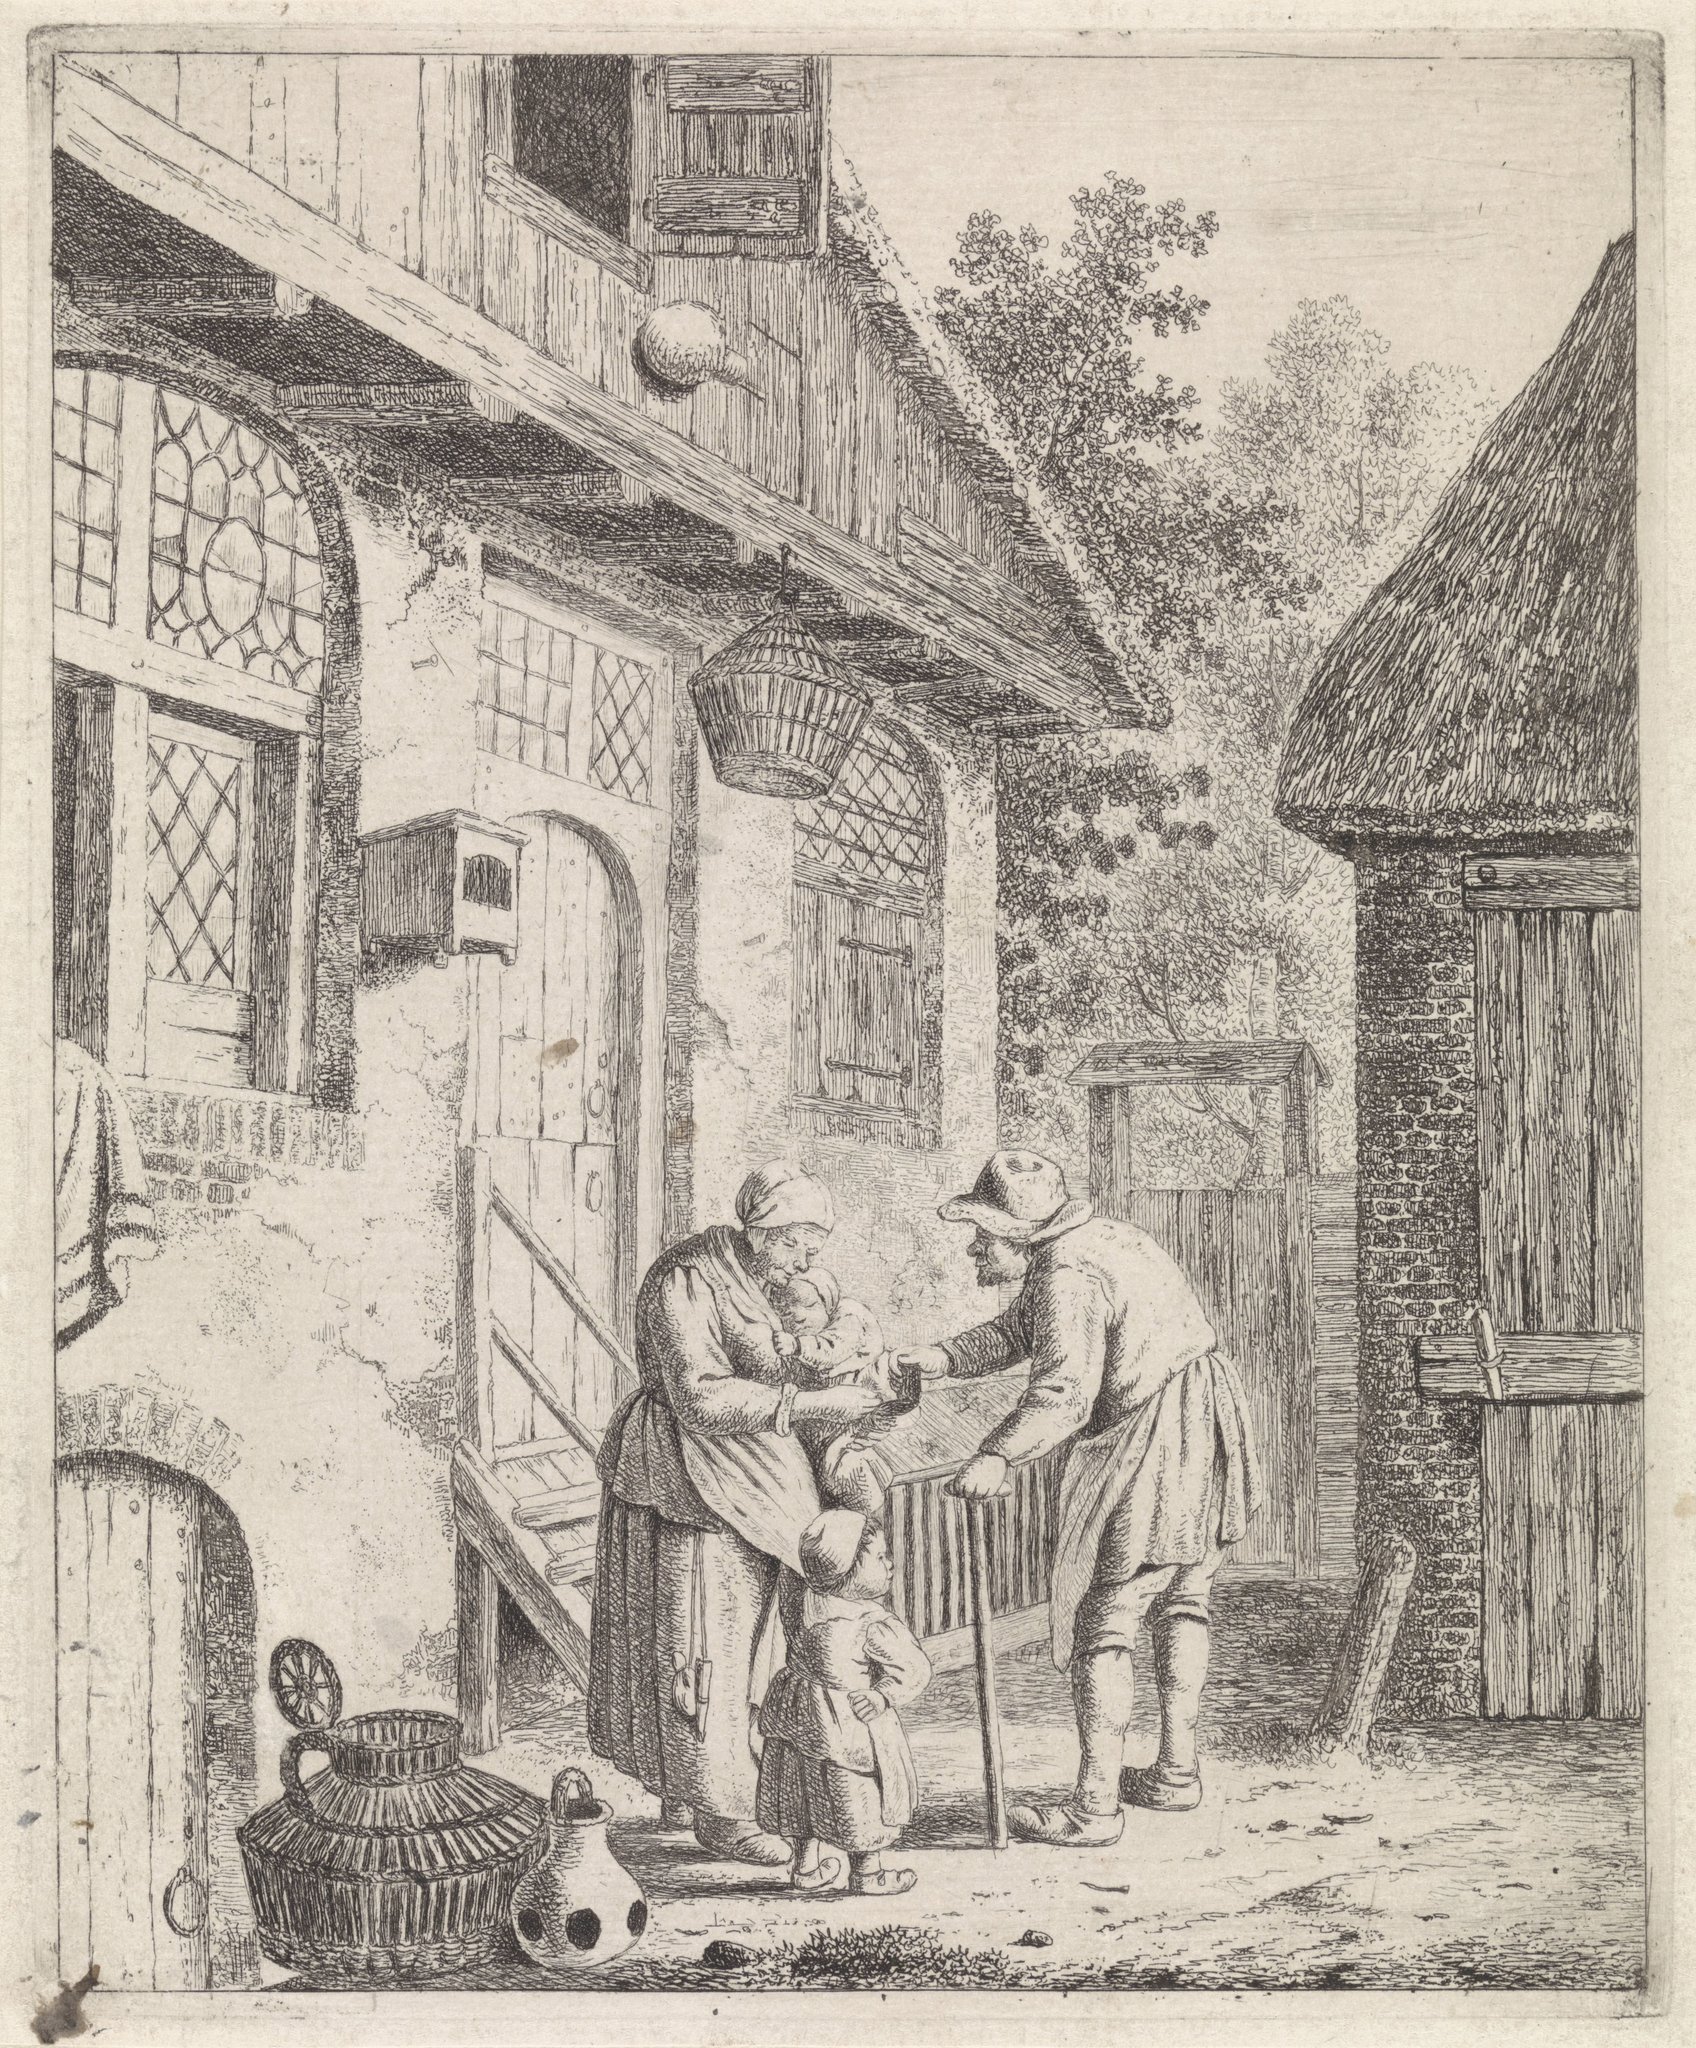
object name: print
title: Binnenplaats met boeren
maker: johannes christiaan janson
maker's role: draughtsman, painter, print maker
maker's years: 1763-1823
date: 1778-1823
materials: paper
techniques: etching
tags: mother and baby or young child, courtyard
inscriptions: collector's mark: Lugt 2228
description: Binnenplaats met een vrouw en twee kinderen voor een huis. De vrouw houdt het jongste kind op haar arm. Voor hen een man, op een stok leunend. Links op de voorgrond een mand en kan. Mét bomen op de achtergrond. Meer bewerkt dan vorige staat.